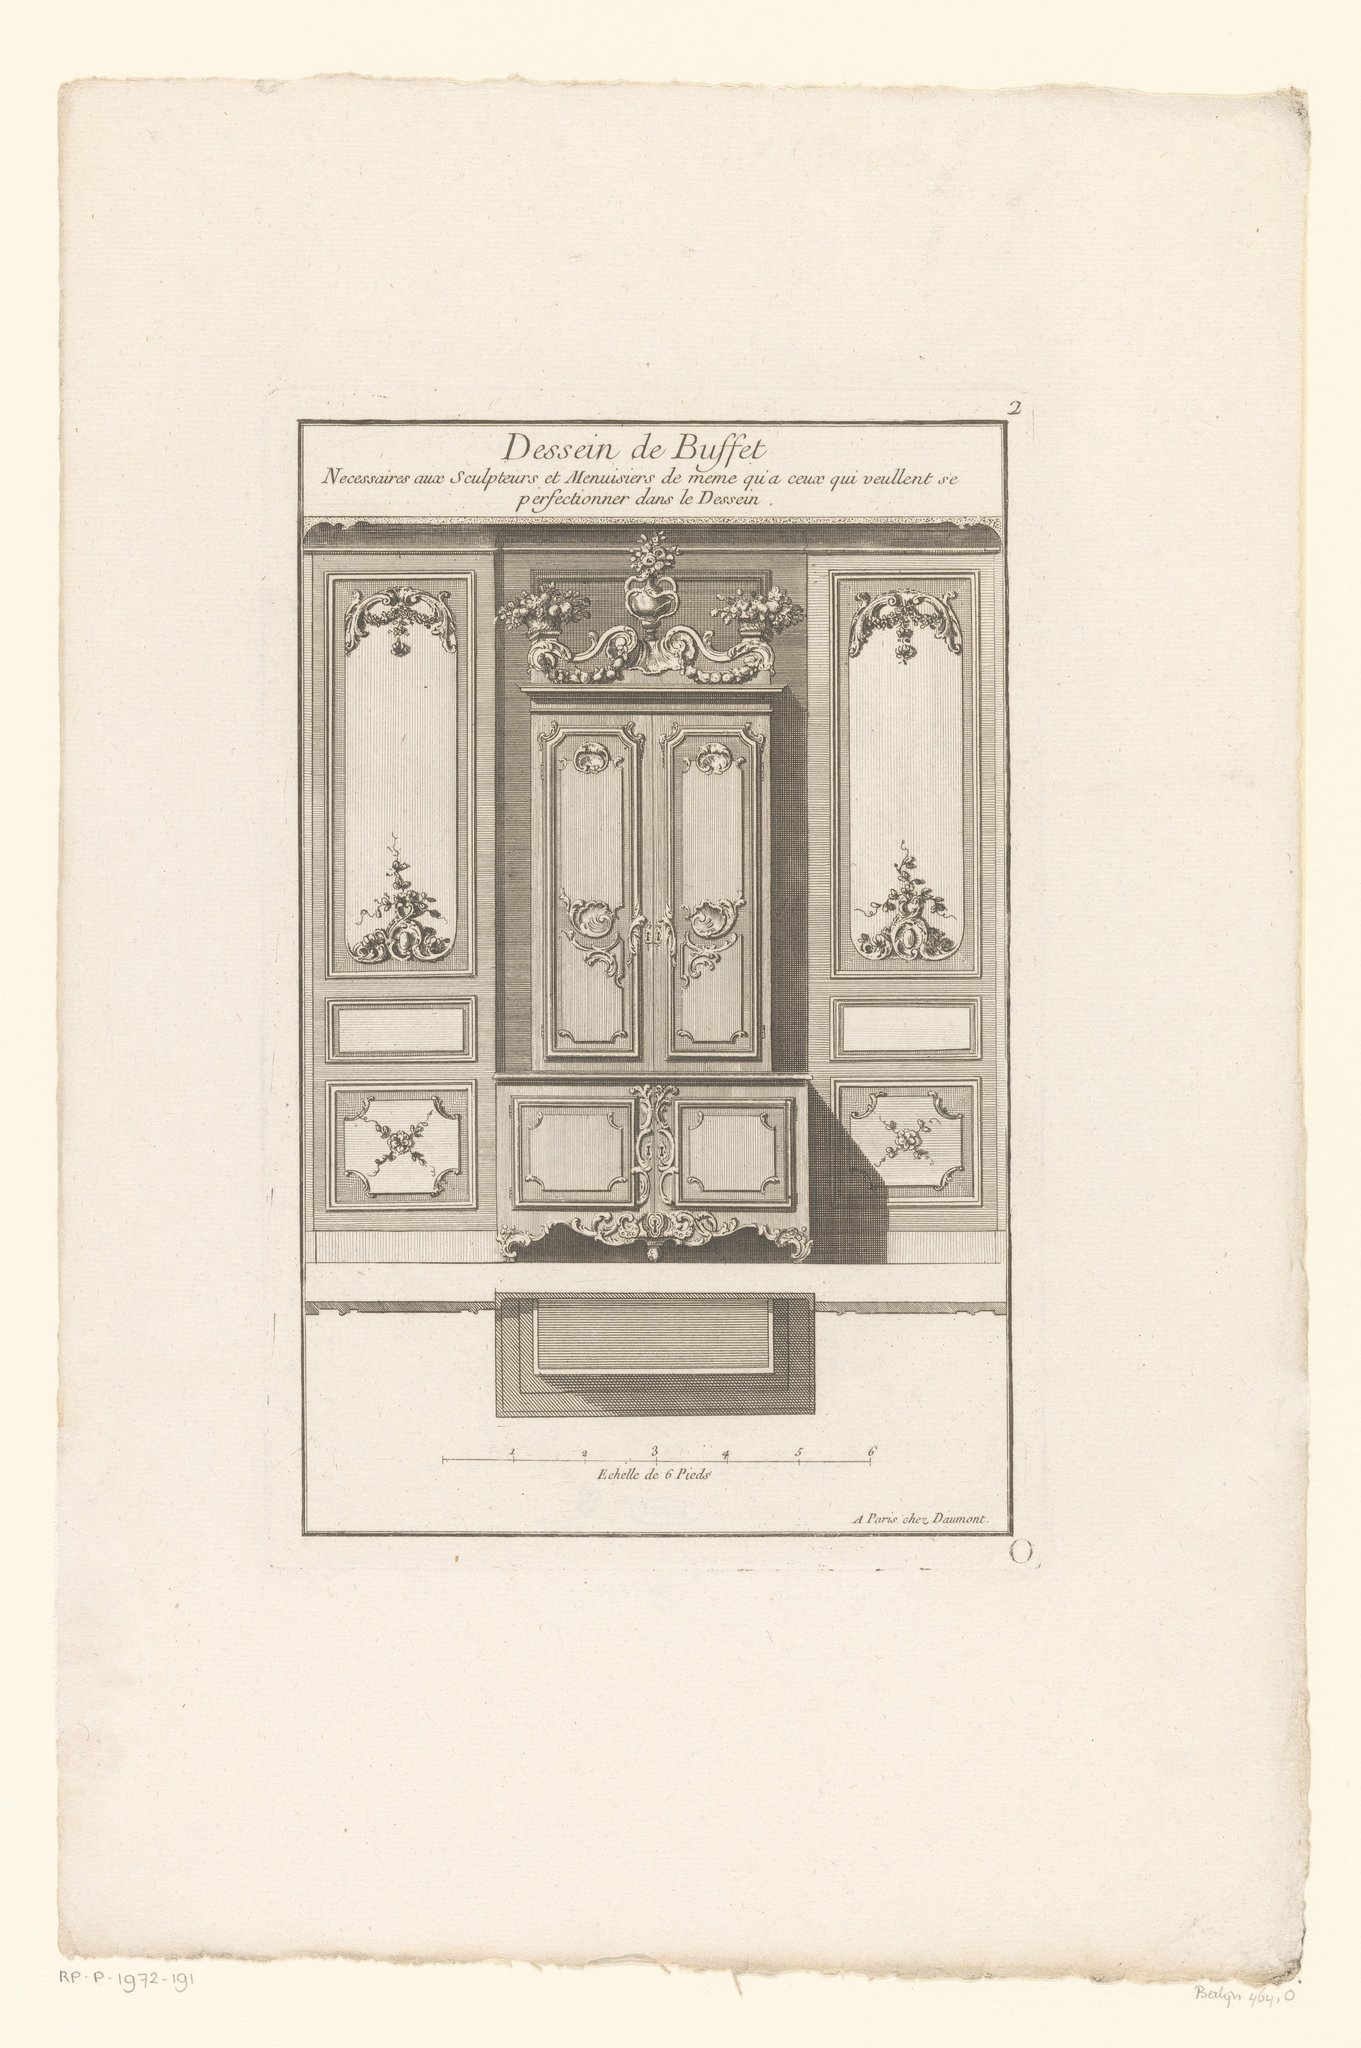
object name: ornament print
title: Dessein de Buffet (...)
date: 1745-1775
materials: paper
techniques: engraving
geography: paris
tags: furniture for storage, panelling, vase ~ ornament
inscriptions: collector's mark: Lugt 2228, collector's mark: Lugt 2760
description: Vooraanzicht en plattegrond van een buffetkast met rocaille ornamenten en aan de bovenzijde drie vazen met bloemen. De kast staat tegen een wand met rocaille panelen.